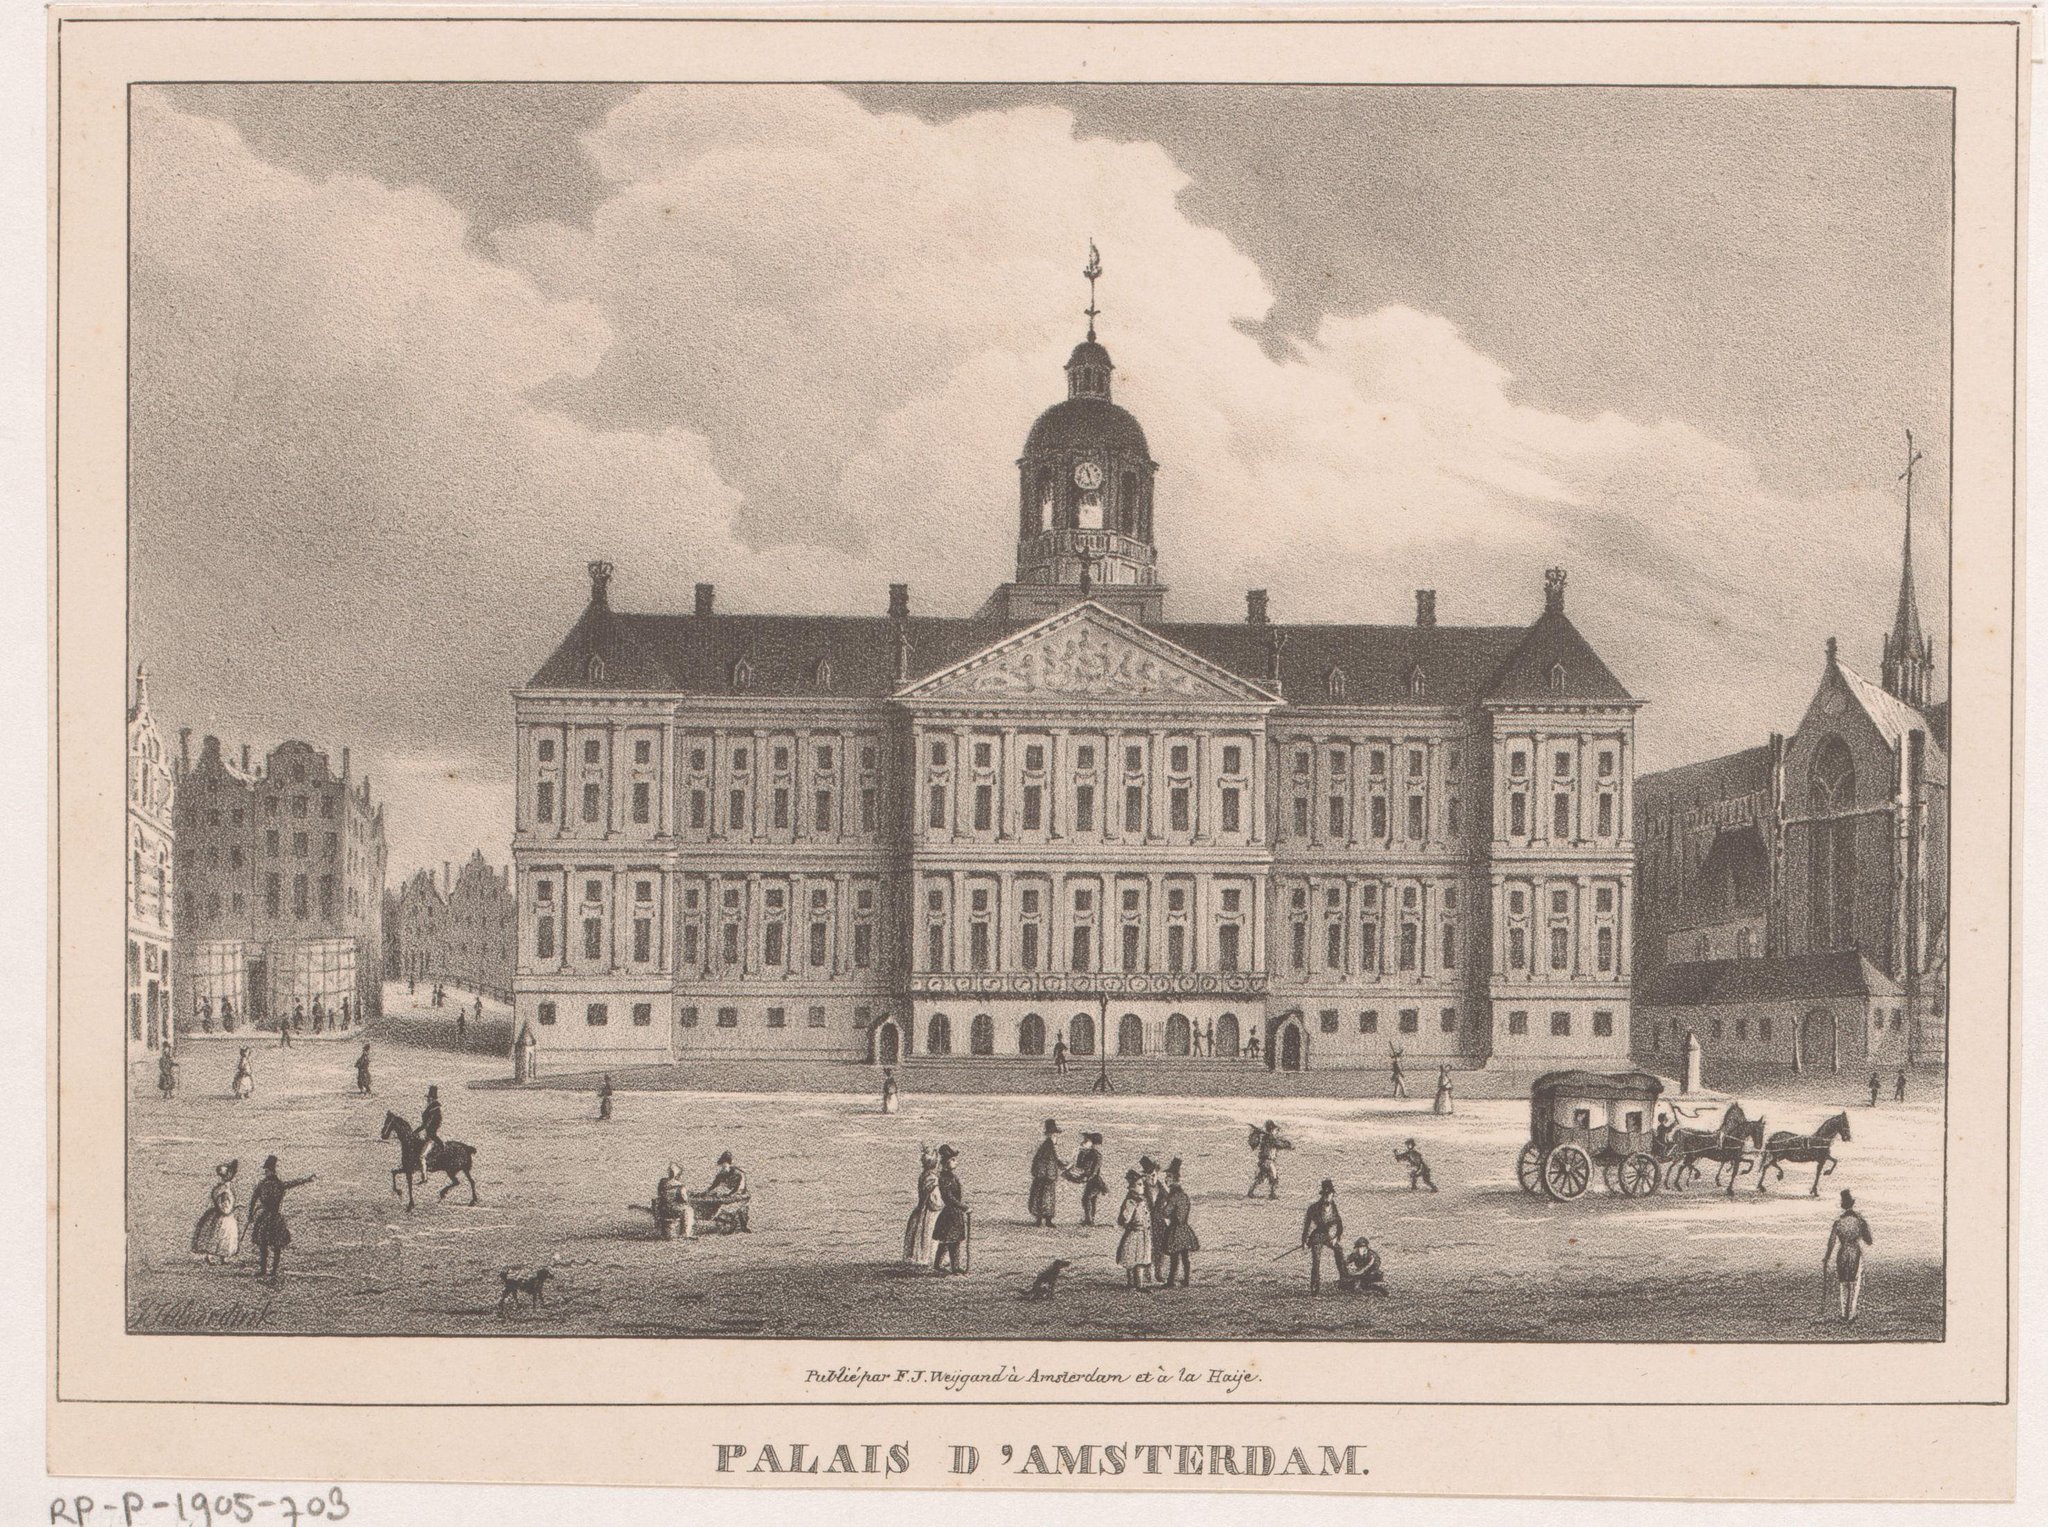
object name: print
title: Koninklijk Paleis op de Dam Amsterdam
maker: jacob johannes josephus hilverdink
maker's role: print maker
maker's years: 1840-1879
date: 1850-1879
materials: paper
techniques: lithograph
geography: amsterdam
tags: palace, village square, place, royal palace of amsterdam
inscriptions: collector's mark: Lugt 2228